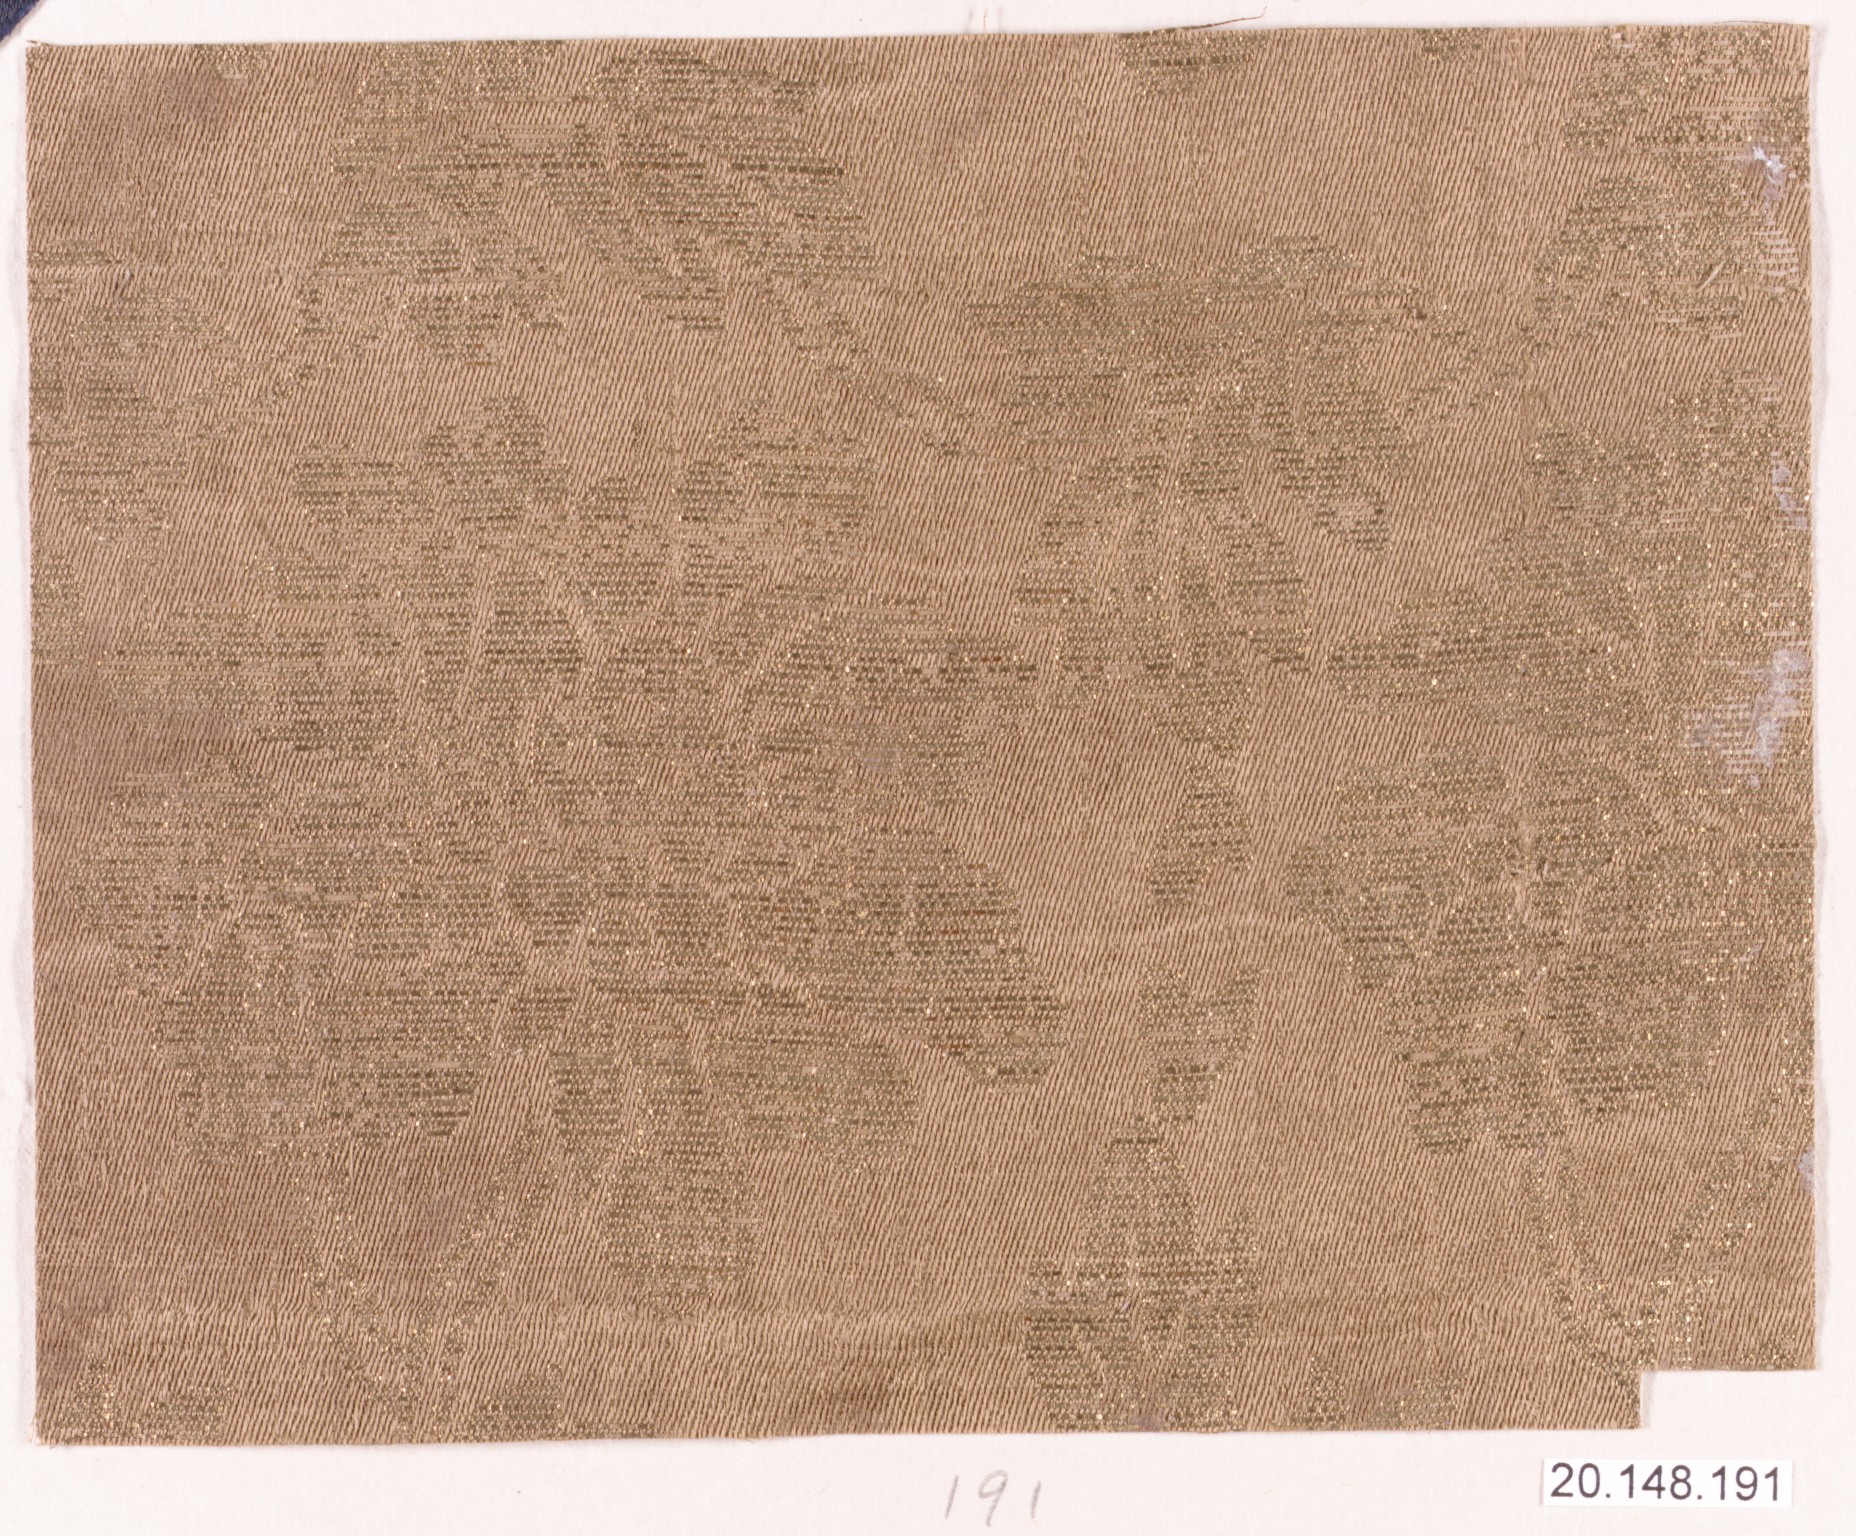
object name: piece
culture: japanese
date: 1601-1700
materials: silk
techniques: compound weave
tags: flowers,leaves